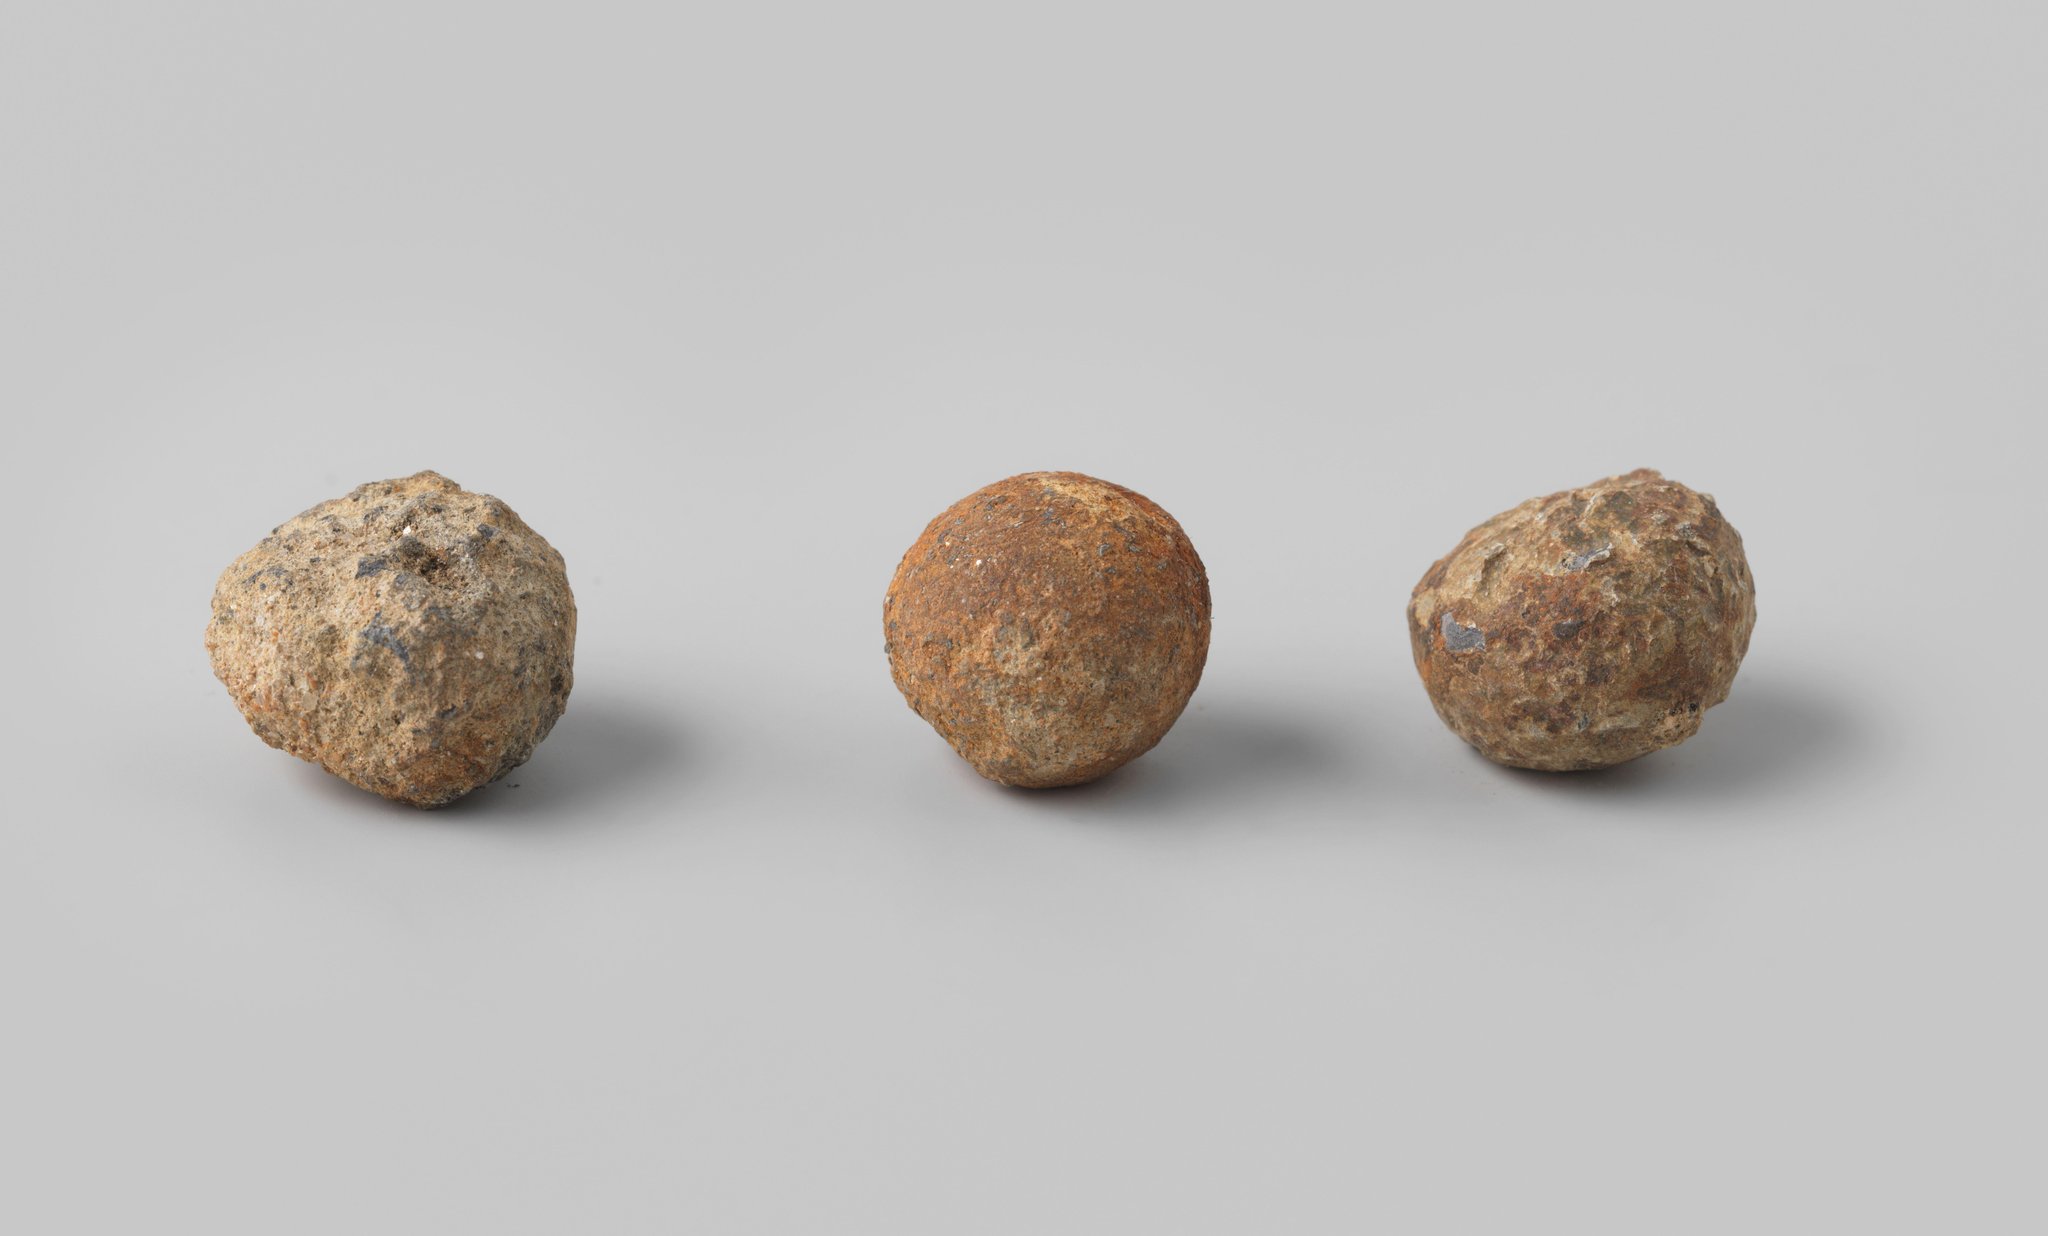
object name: musketkogel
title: Musketkogels uit het wrak van de Oost-Indiëvaarder Hollandia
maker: Anonymous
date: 1700-1743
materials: lead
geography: netherlands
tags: verenigde oostindische compagnie, hollandia (schip), annet